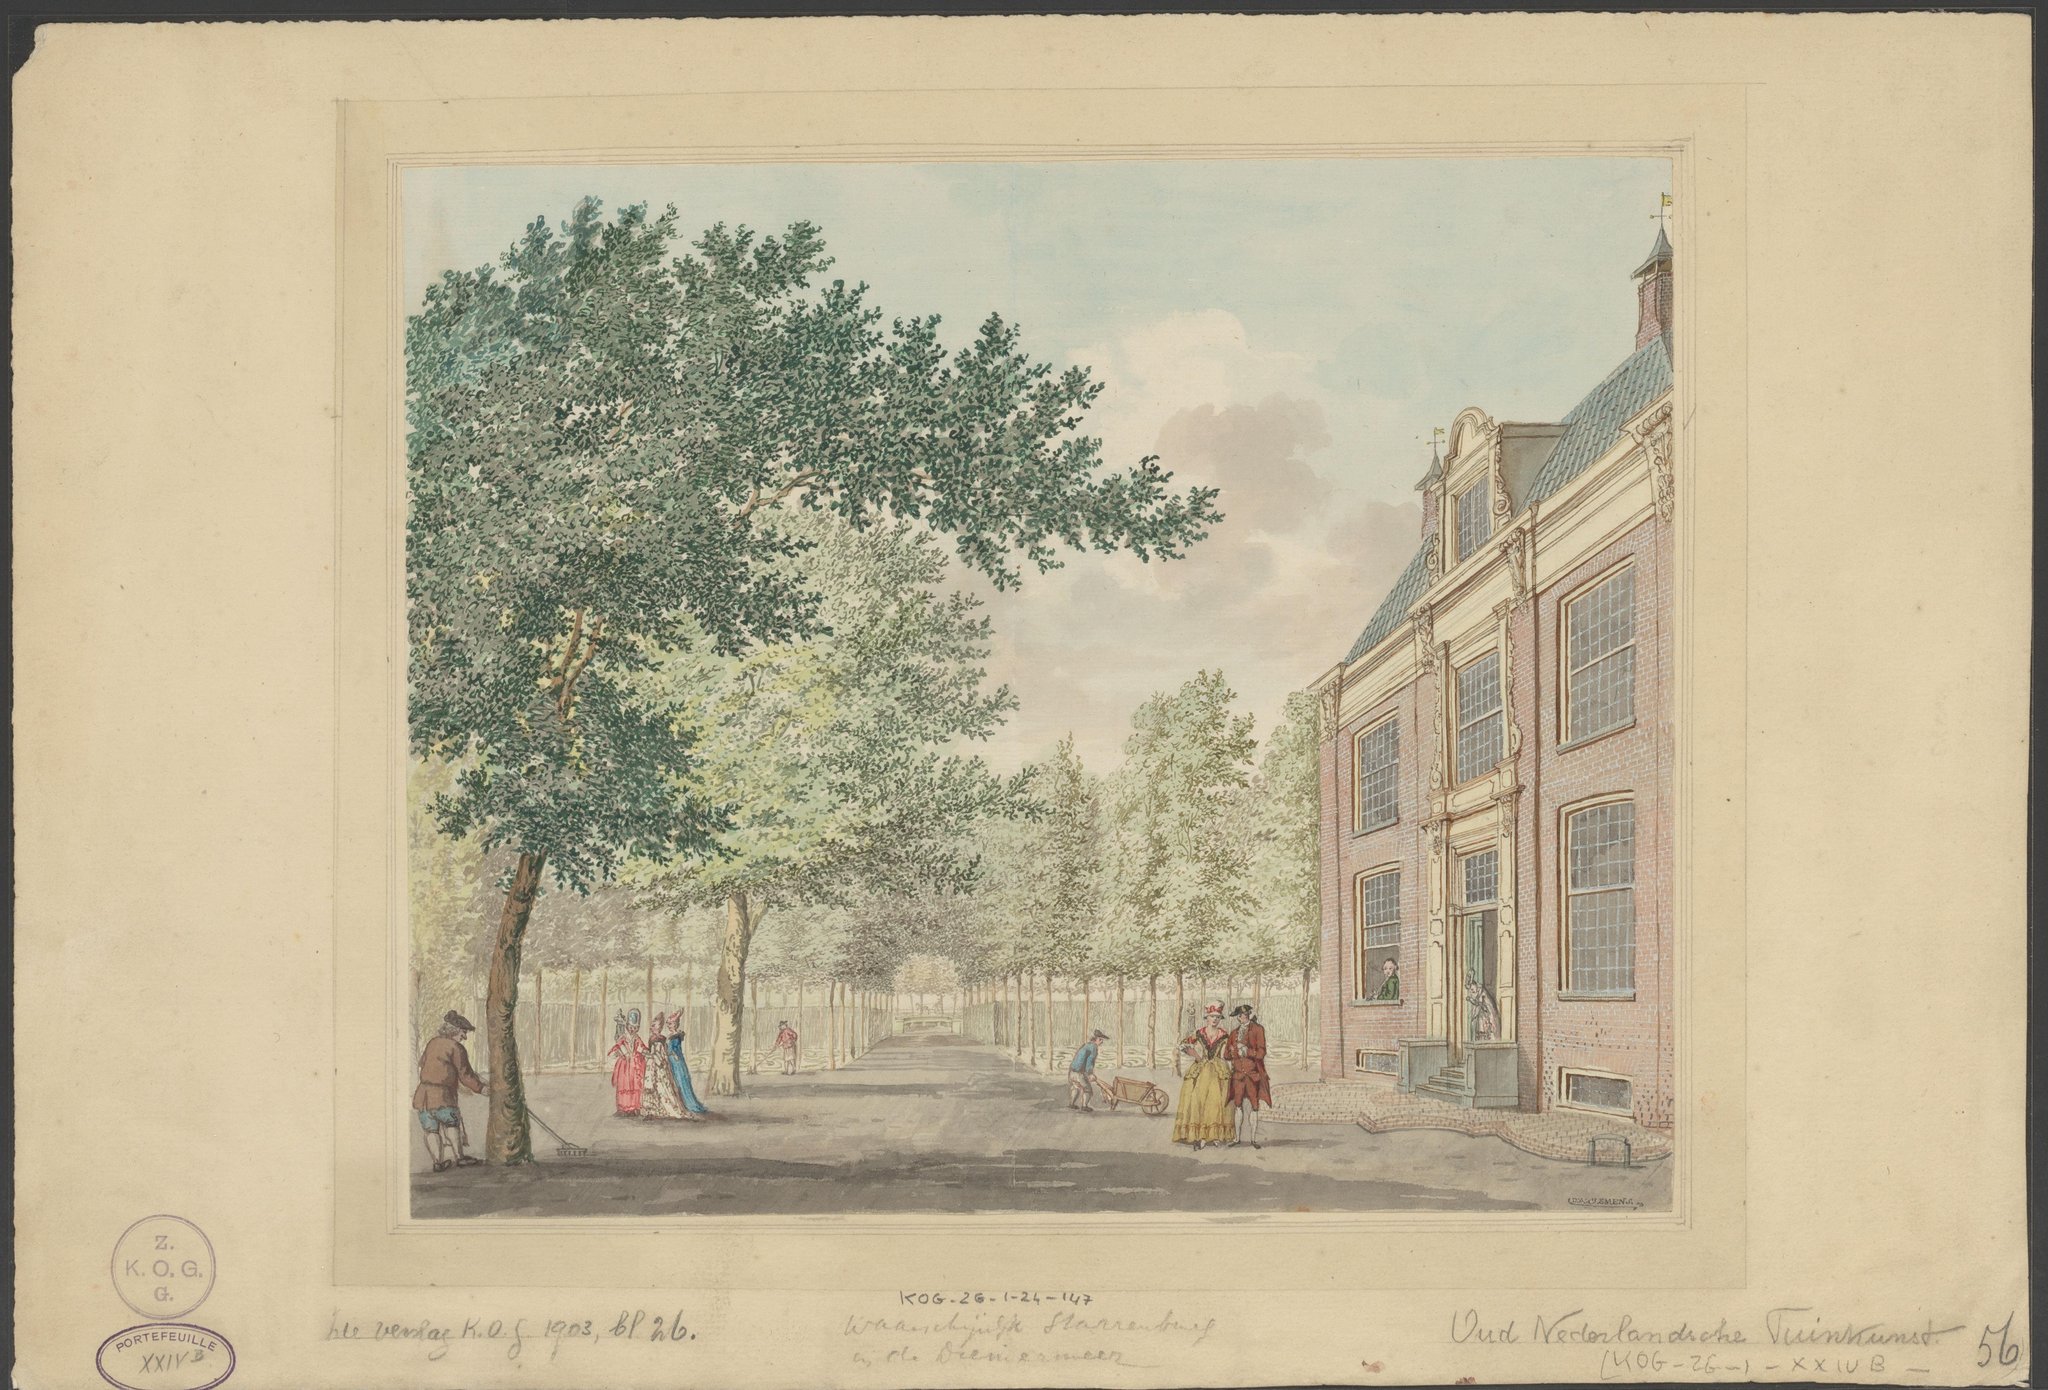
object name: drawing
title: Gezicht op een laan van een buitenplaats, mogelijk Starrenburg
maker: dirk abraham clemens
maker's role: draughtsman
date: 1775-1825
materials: paper, watercolor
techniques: brush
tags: lane, alley, country-house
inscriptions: stamp, collector's mark: Lugt 1641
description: Rechts de voorgevel van een buitenplaats, mogelijk Starrenburg in de Diemermeer. Op het voorplein diverse wandelaars en tuinlieden. Vanuit het voorplein kijkt men in een brede laan met aan weerszijden decoratieve perken en hoge geschoren hagen waarlangs bomen. Onderwerpsrubrieken binnen de Atlas Zeden en Gewoonten: Zeden en Gewoonten in Engeren Zin, De Woning, Oude Nederlandsche Tuinkunst. De kasteeltuin.